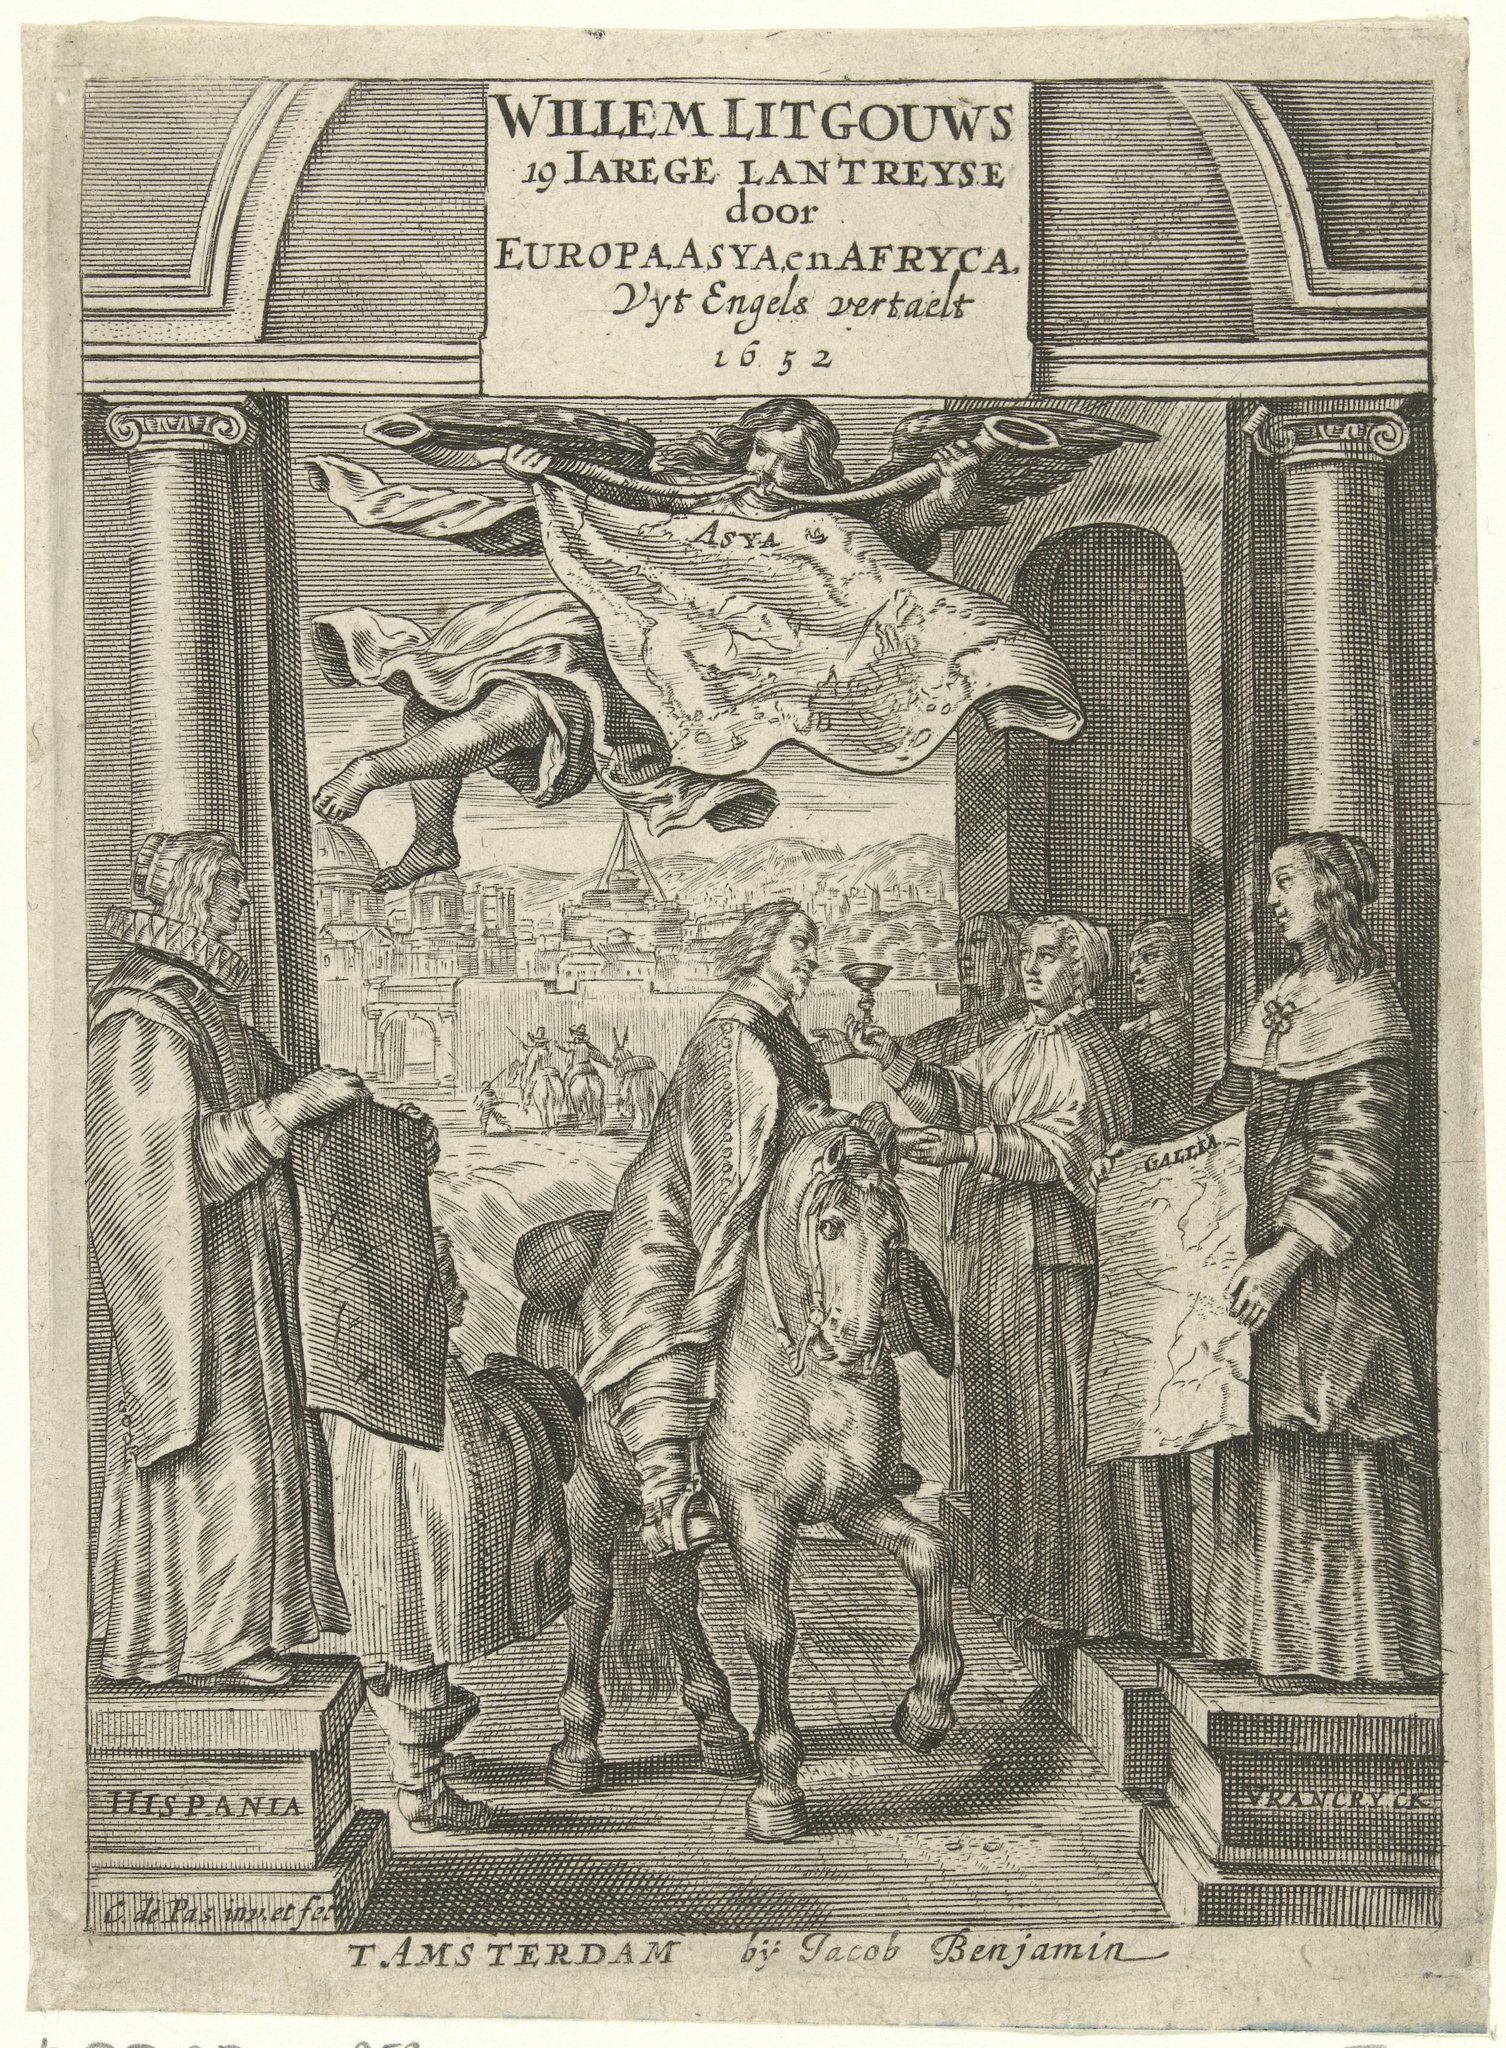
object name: print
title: Reiziger wordt ontvangen bij stadspoort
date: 1652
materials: paper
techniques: engraving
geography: amsterdam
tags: personifications of countries, nations, states, districts, etc., frontispiece, being welcomed ~ travelling, fame; 'fama', 'fama buona', 'fama chiara' (ripa), city-gate, rome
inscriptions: collector's mark: Lugt 2228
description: Een reiziger te paard wordt door drie vrouwen ontvangen bij een stadspoort. Aan weerszijden de vrouwelijke personificaties van Spanje en Frankrijk, die de kaarten van hun land vasthouden. Boven de reiziger Faam met de kaart van Azië. Op de achtergrond een gezicht op Rome.